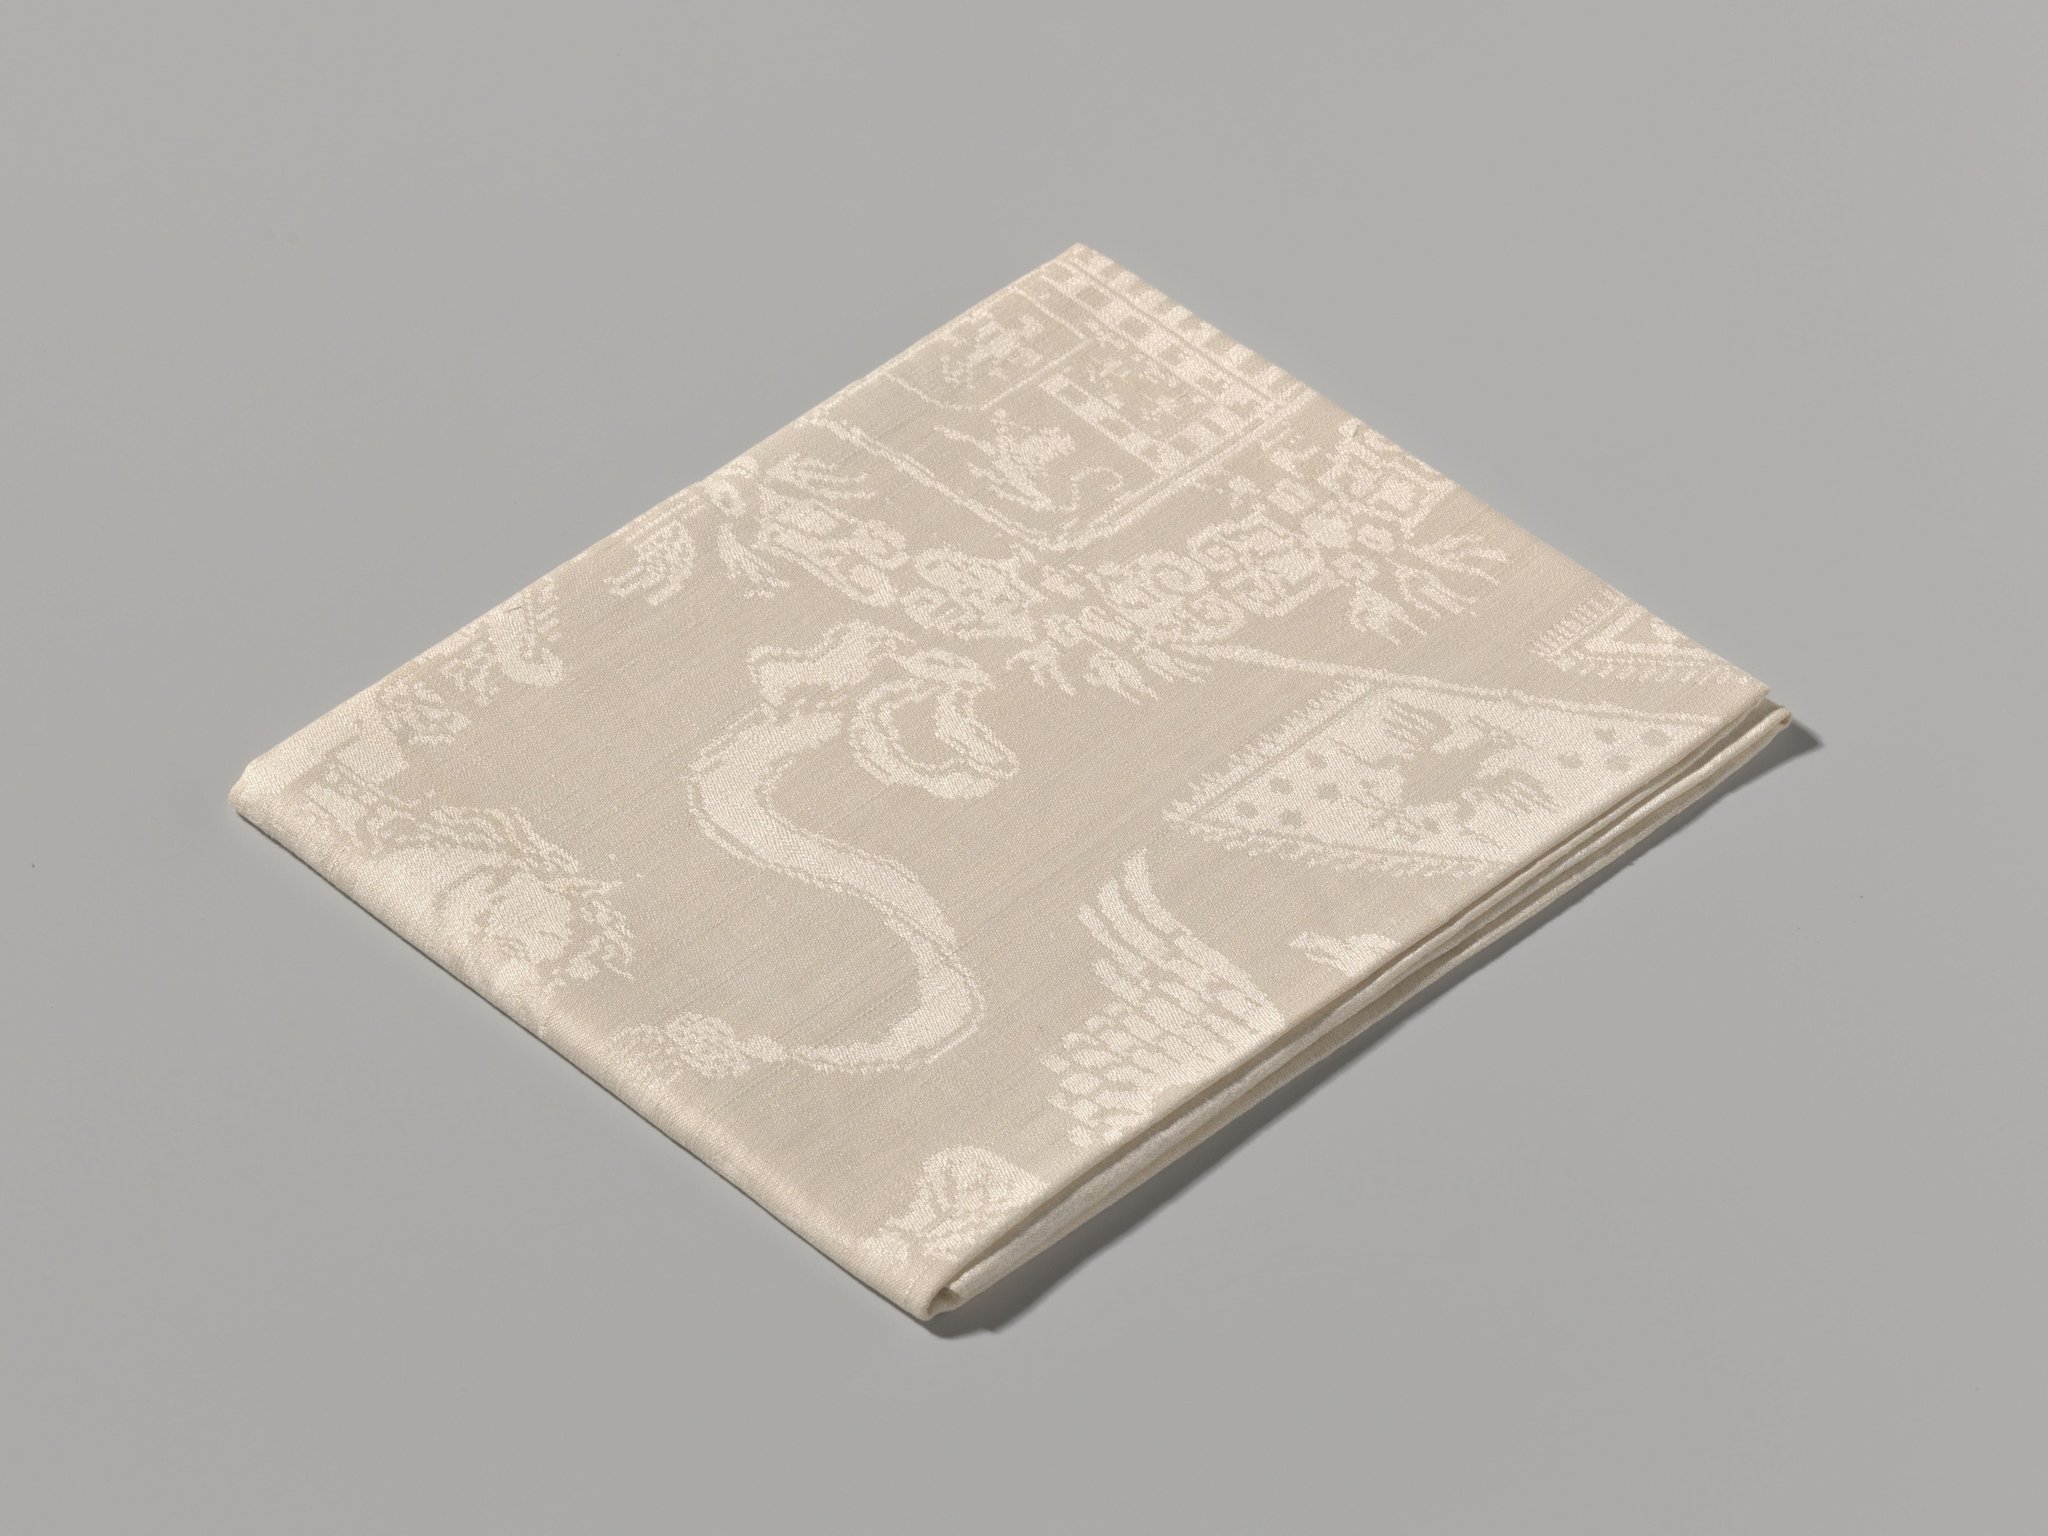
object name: napkin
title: Servet met het wapen van Karel III van Spanje en een gezicht op Rijssel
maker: Anonymous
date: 1702-1713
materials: linen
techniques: damask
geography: kortrijk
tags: charles vi (holy roman emperor), lille, spain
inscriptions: mark: ‘? S’, mark: ‘13’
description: Servet van linnendamast met het wapen van Karel III van Spanje en een gezicht op Rijssel. Het symmetrisch patroon vertoont van onder naar boven de volgende taferelen: 1 Een gezicht op Rijssel met vele torens. 2 Plattegrond van een vesting met bovenschrift LILLE. 3 Ruiter te paard (Karel III van Spanje?). 4 Het wapen van Karel III van Spanje geflankeerd door vaandels. Staande en liggende randen: wapens, onder andere Savoye, en wapentrofeeën; daarbuiten: blokkenrand.